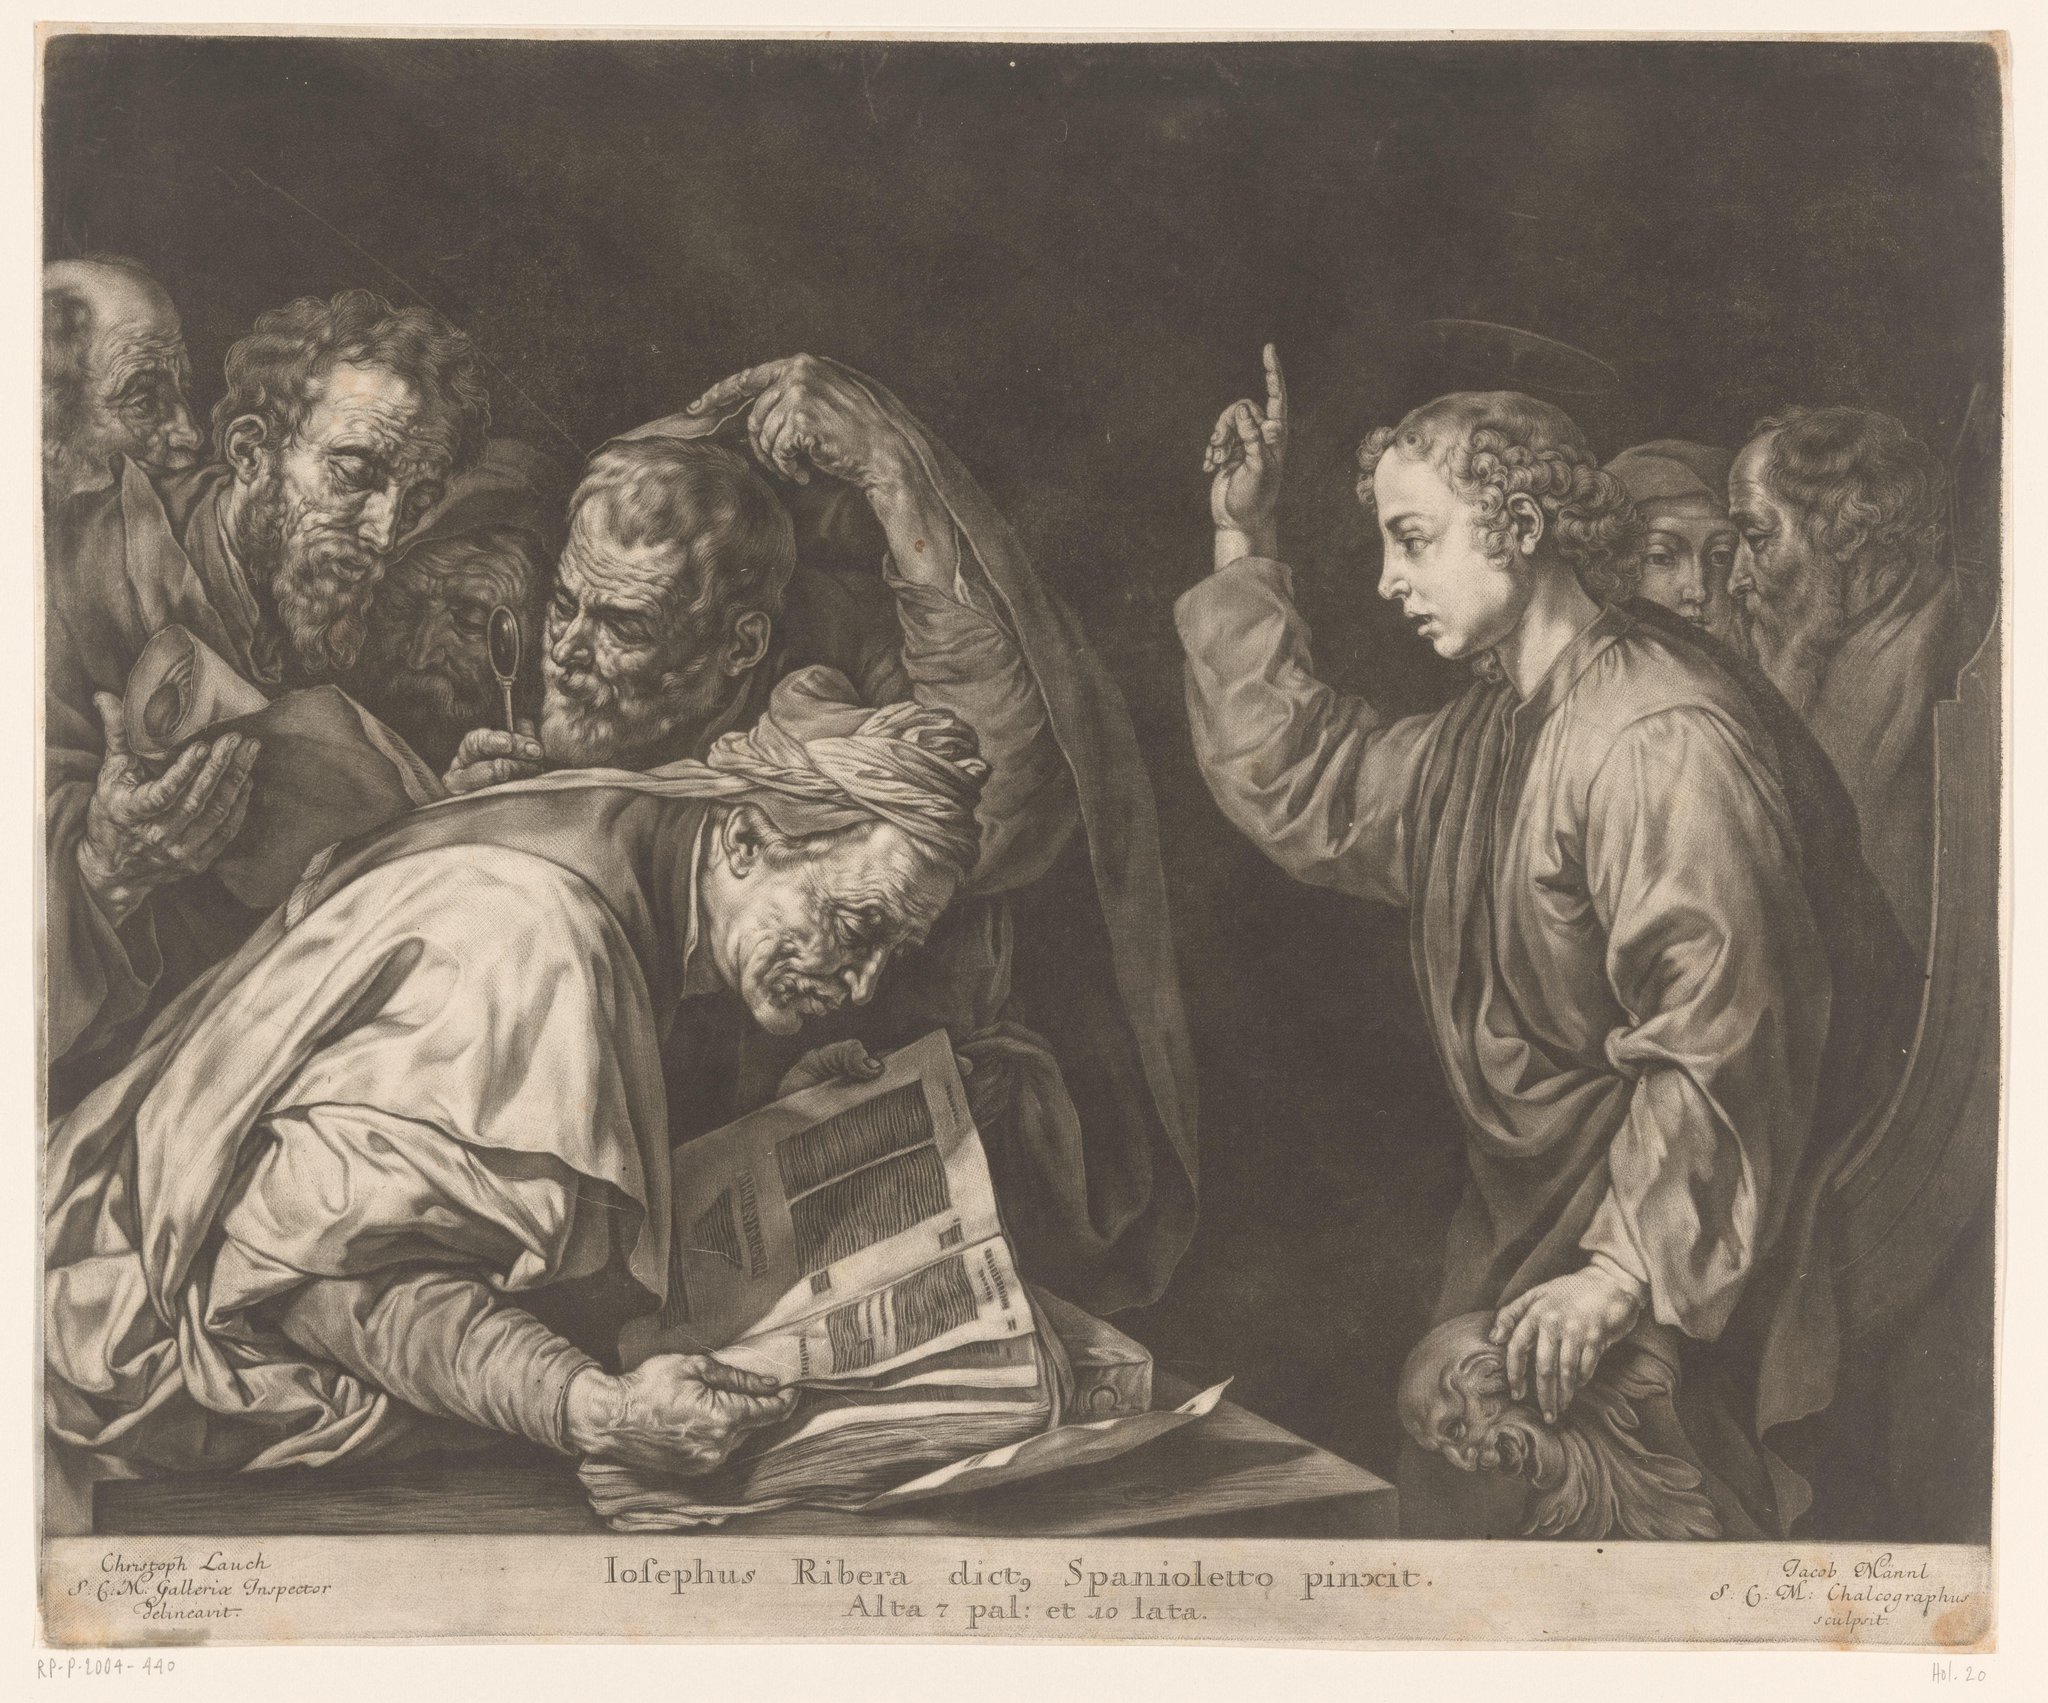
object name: print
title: Christus en de schriftgeleerden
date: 1663-1712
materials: paper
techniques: mezzotint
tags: christ's dispute with the doctors in the temple; he counts his arguments on his fingers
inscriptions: collector's mark: Lugt 2760, collector's mark: Lugt 2228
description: Onderdeel van een serie van 34 mezzotinten naar schilderijen in de keizerlijke galerij in Wenen.